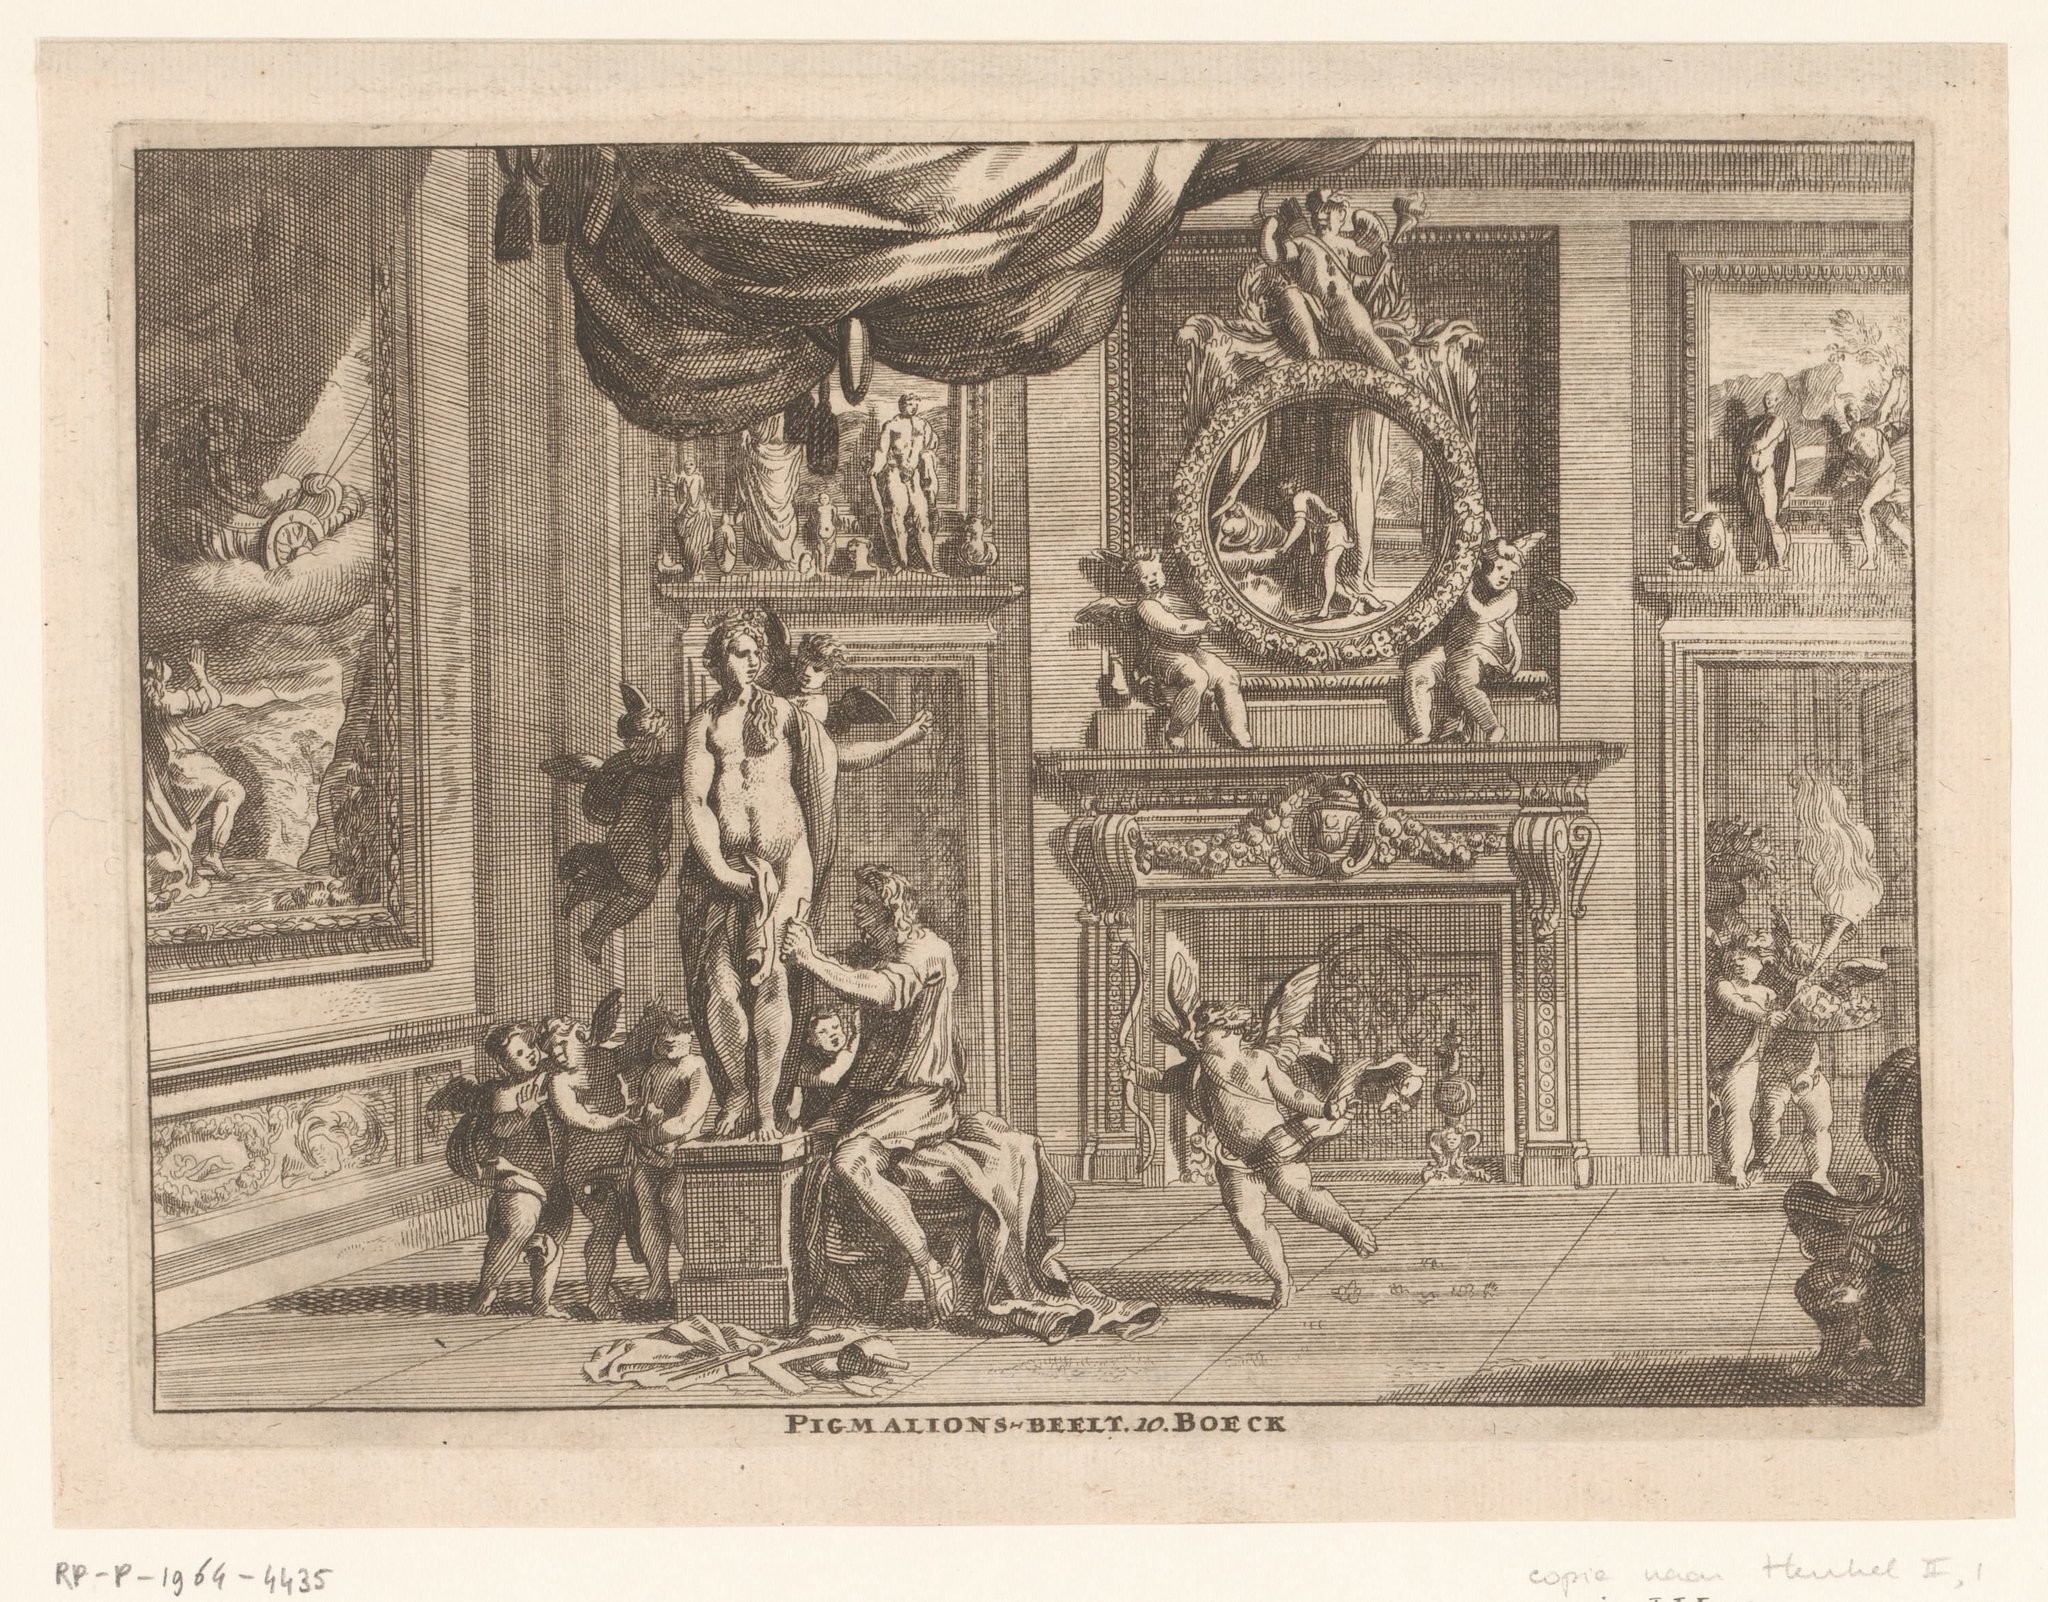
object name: print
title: Pigmalions Beelt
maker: Anonymous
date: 1628-1682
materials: paper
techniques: etching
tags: pygmalion falls in love with the statue he is carving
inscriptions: collector's mark: Lugt 2228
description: Lijkt deel uit te maken van een serie prenten met mythologische onderwerpen, naar prenten door Jean Lepautre en voorzien van Nederlandse titels. Mogelijk werd de serie uitgegeven door Cornelis (I) of Cornelis (II) Danckerts, zoals vermeld op RP-P-1964-4431 en RP-P-1964-4443.